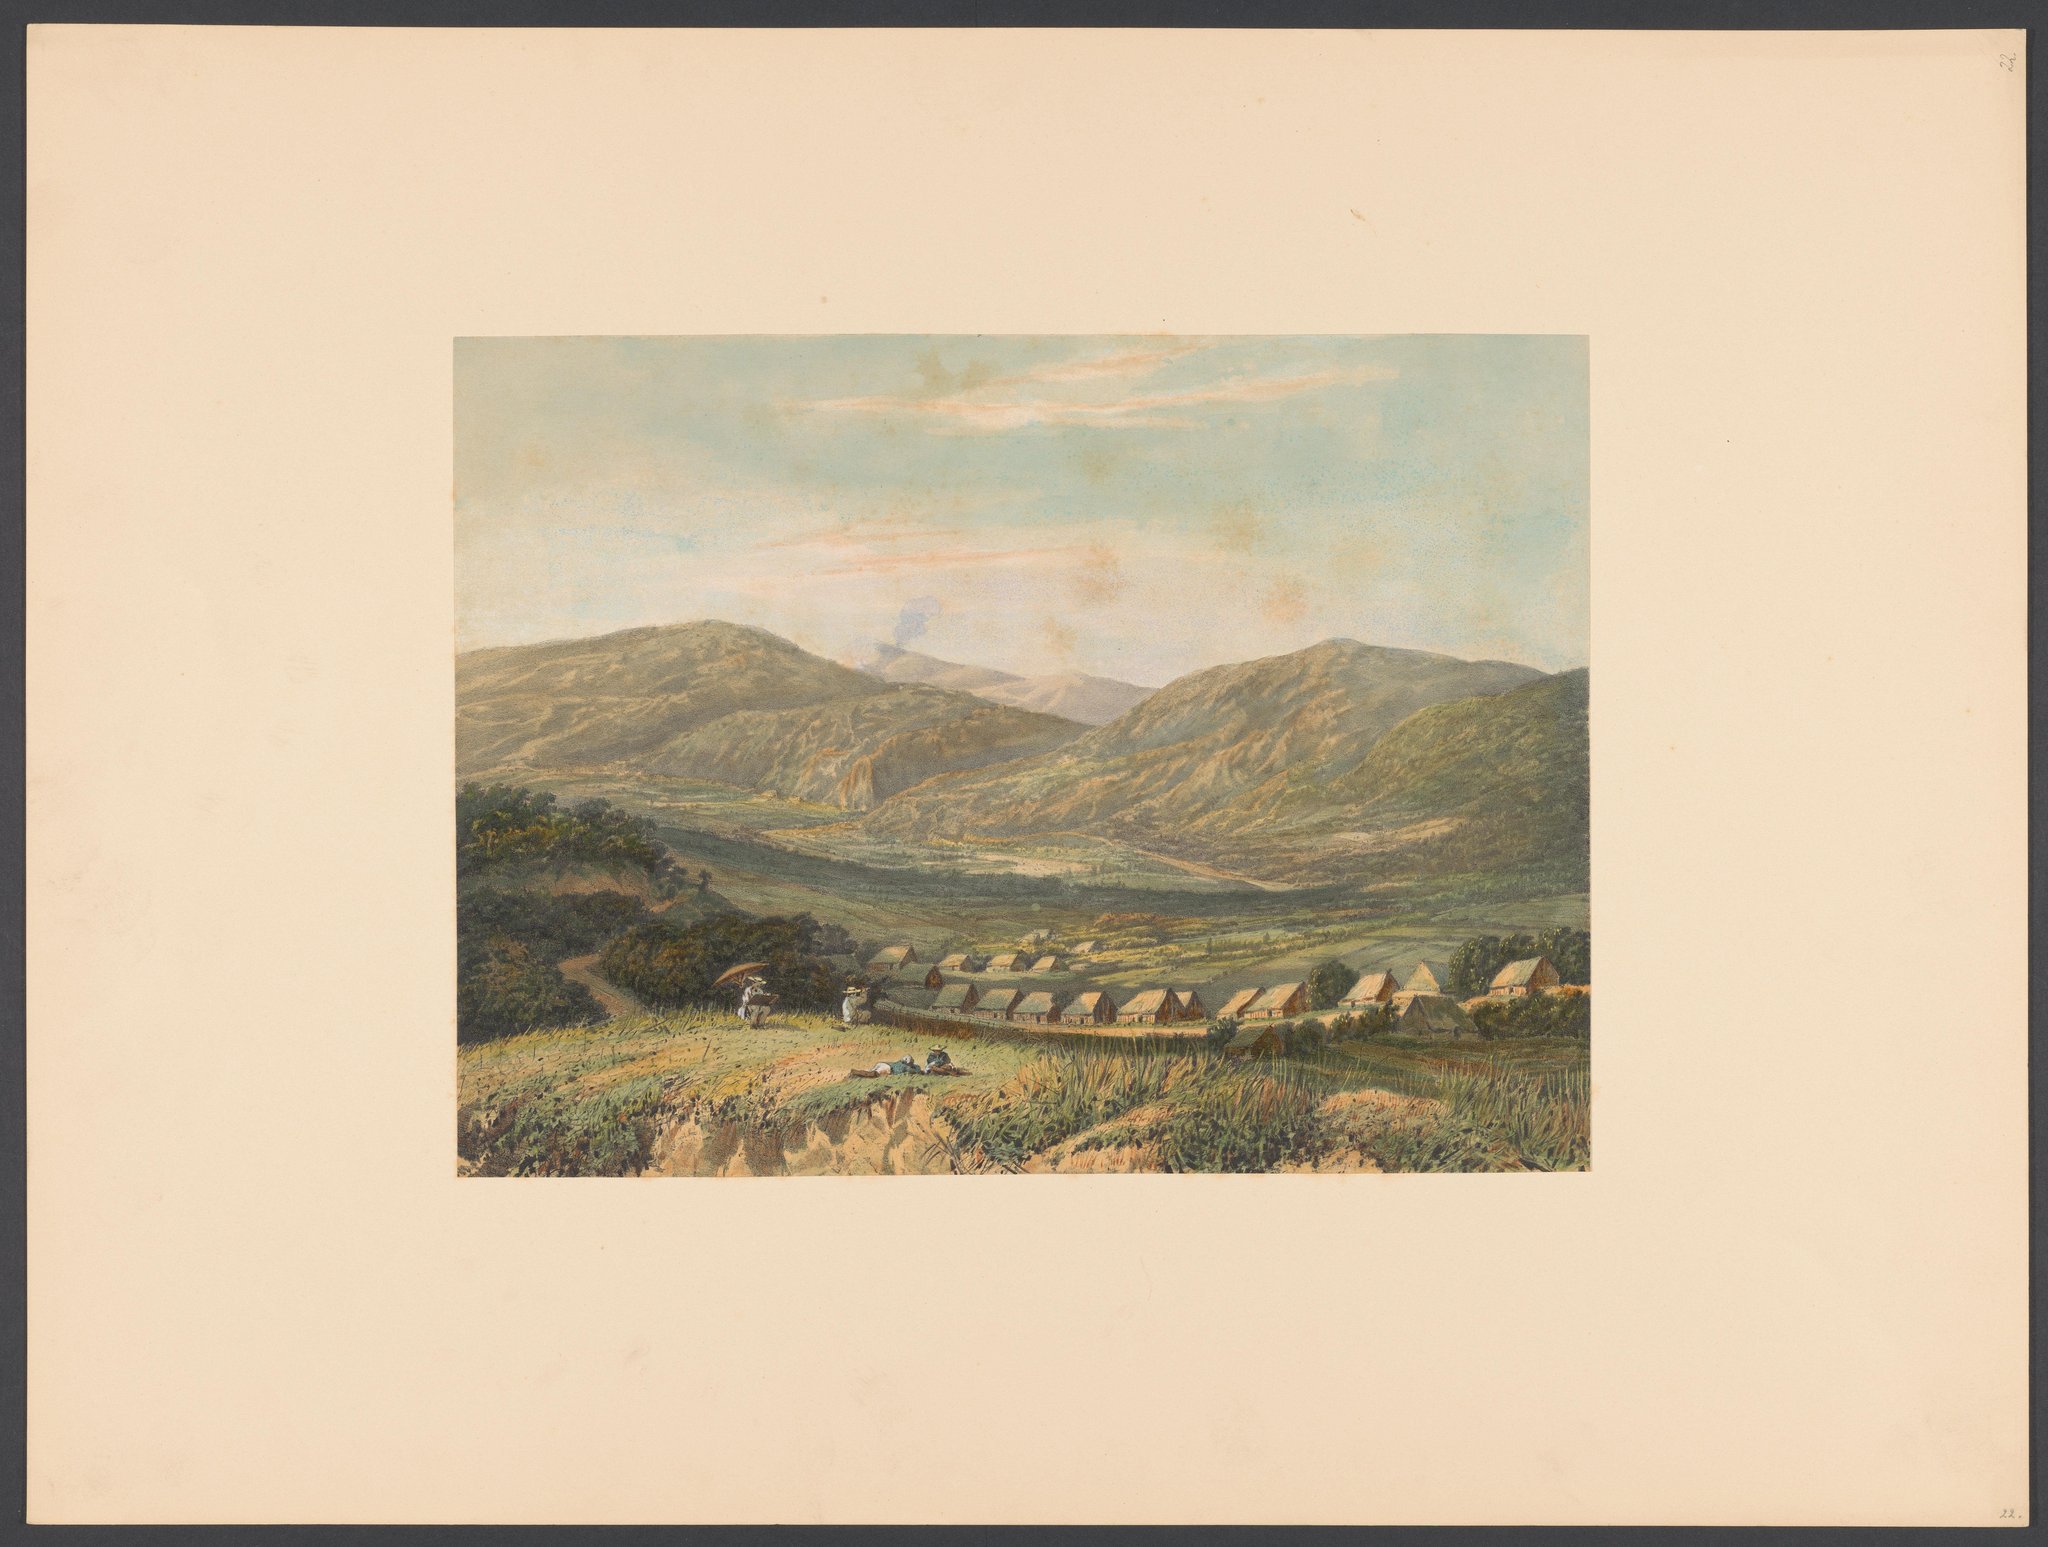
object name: print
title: Java naar schilderijen en teekeningen van A. Salm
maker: johan conrad greive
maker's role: draughtsman, painter, print maker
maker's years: 1837-1891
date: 1865-1872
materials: paper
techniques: lithograph, hand coloring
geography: amsterdam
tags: amsterdam, painter, abraham salm, draughtsman at work - cc - out of doors, landscapes (+ landscape with figures, staffage), portrait, self-portrait of draughtsman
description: Mogelijk heeft Abraham Salm zichzelf hier afgebeeld. De prent maakt deel uit van een map met 24 bladen.